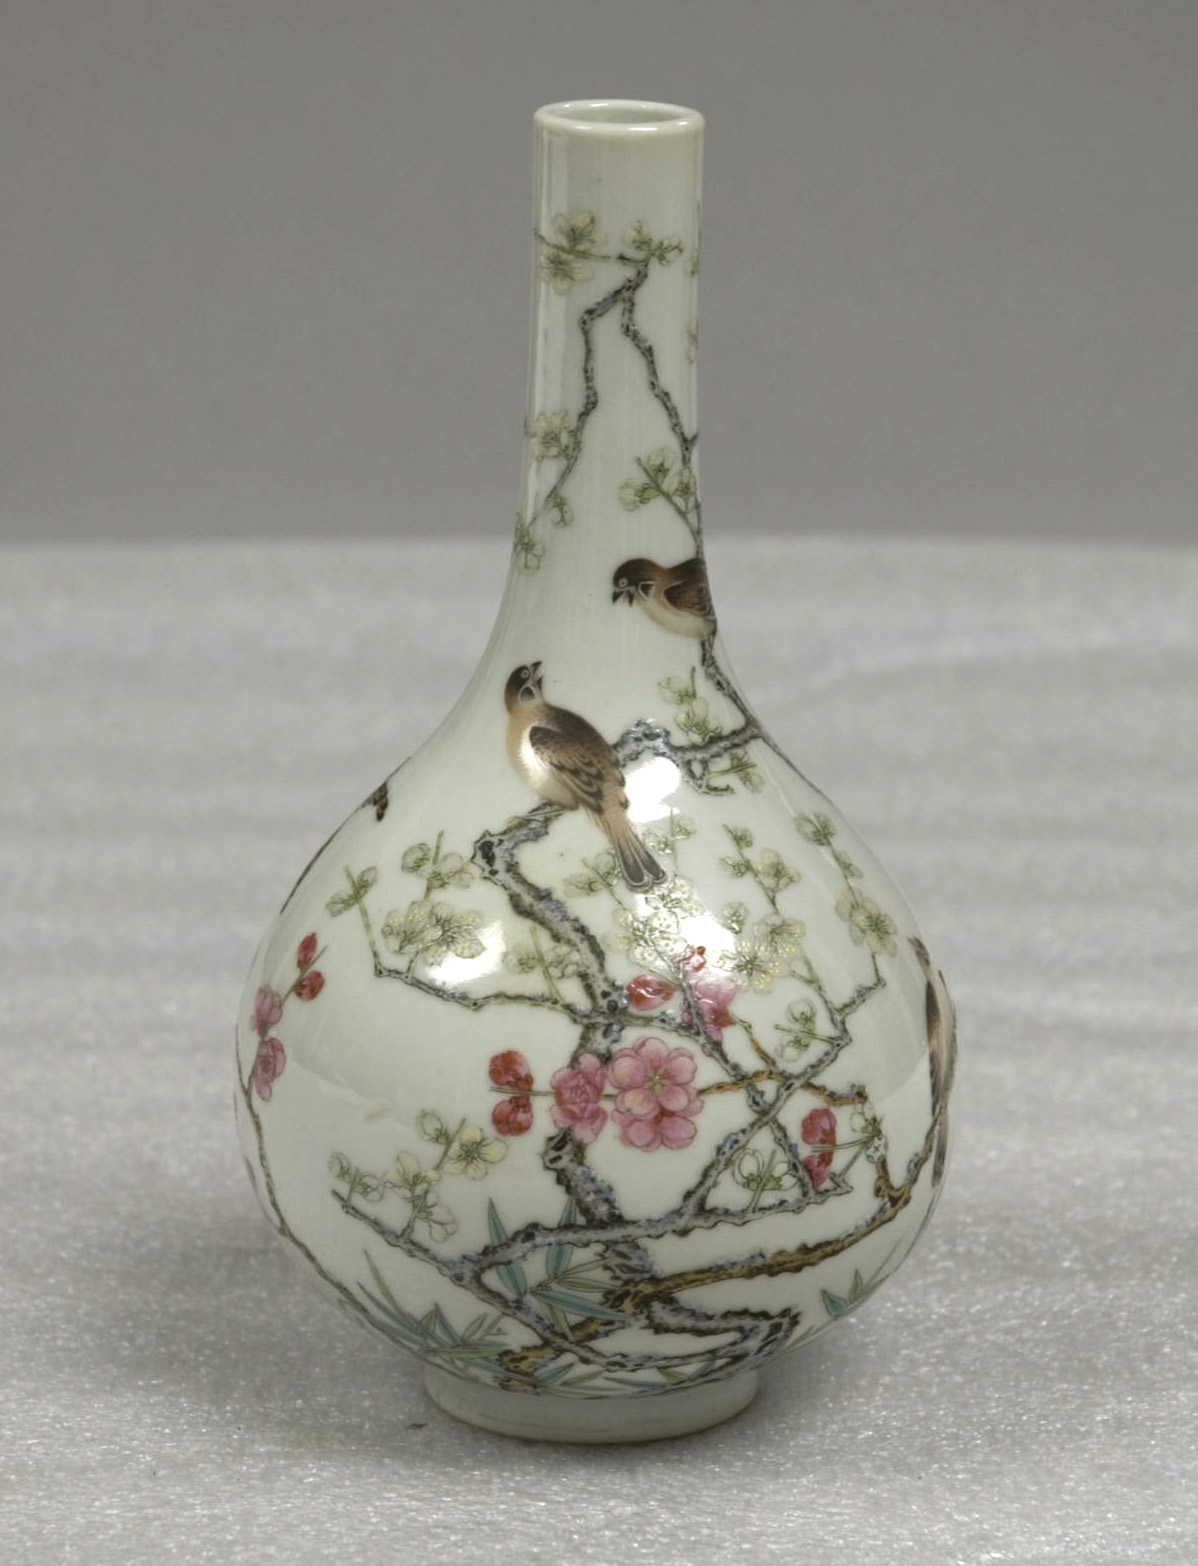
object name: bottle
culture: chinese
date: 1723-1735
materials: porcelain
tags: birds,flowers